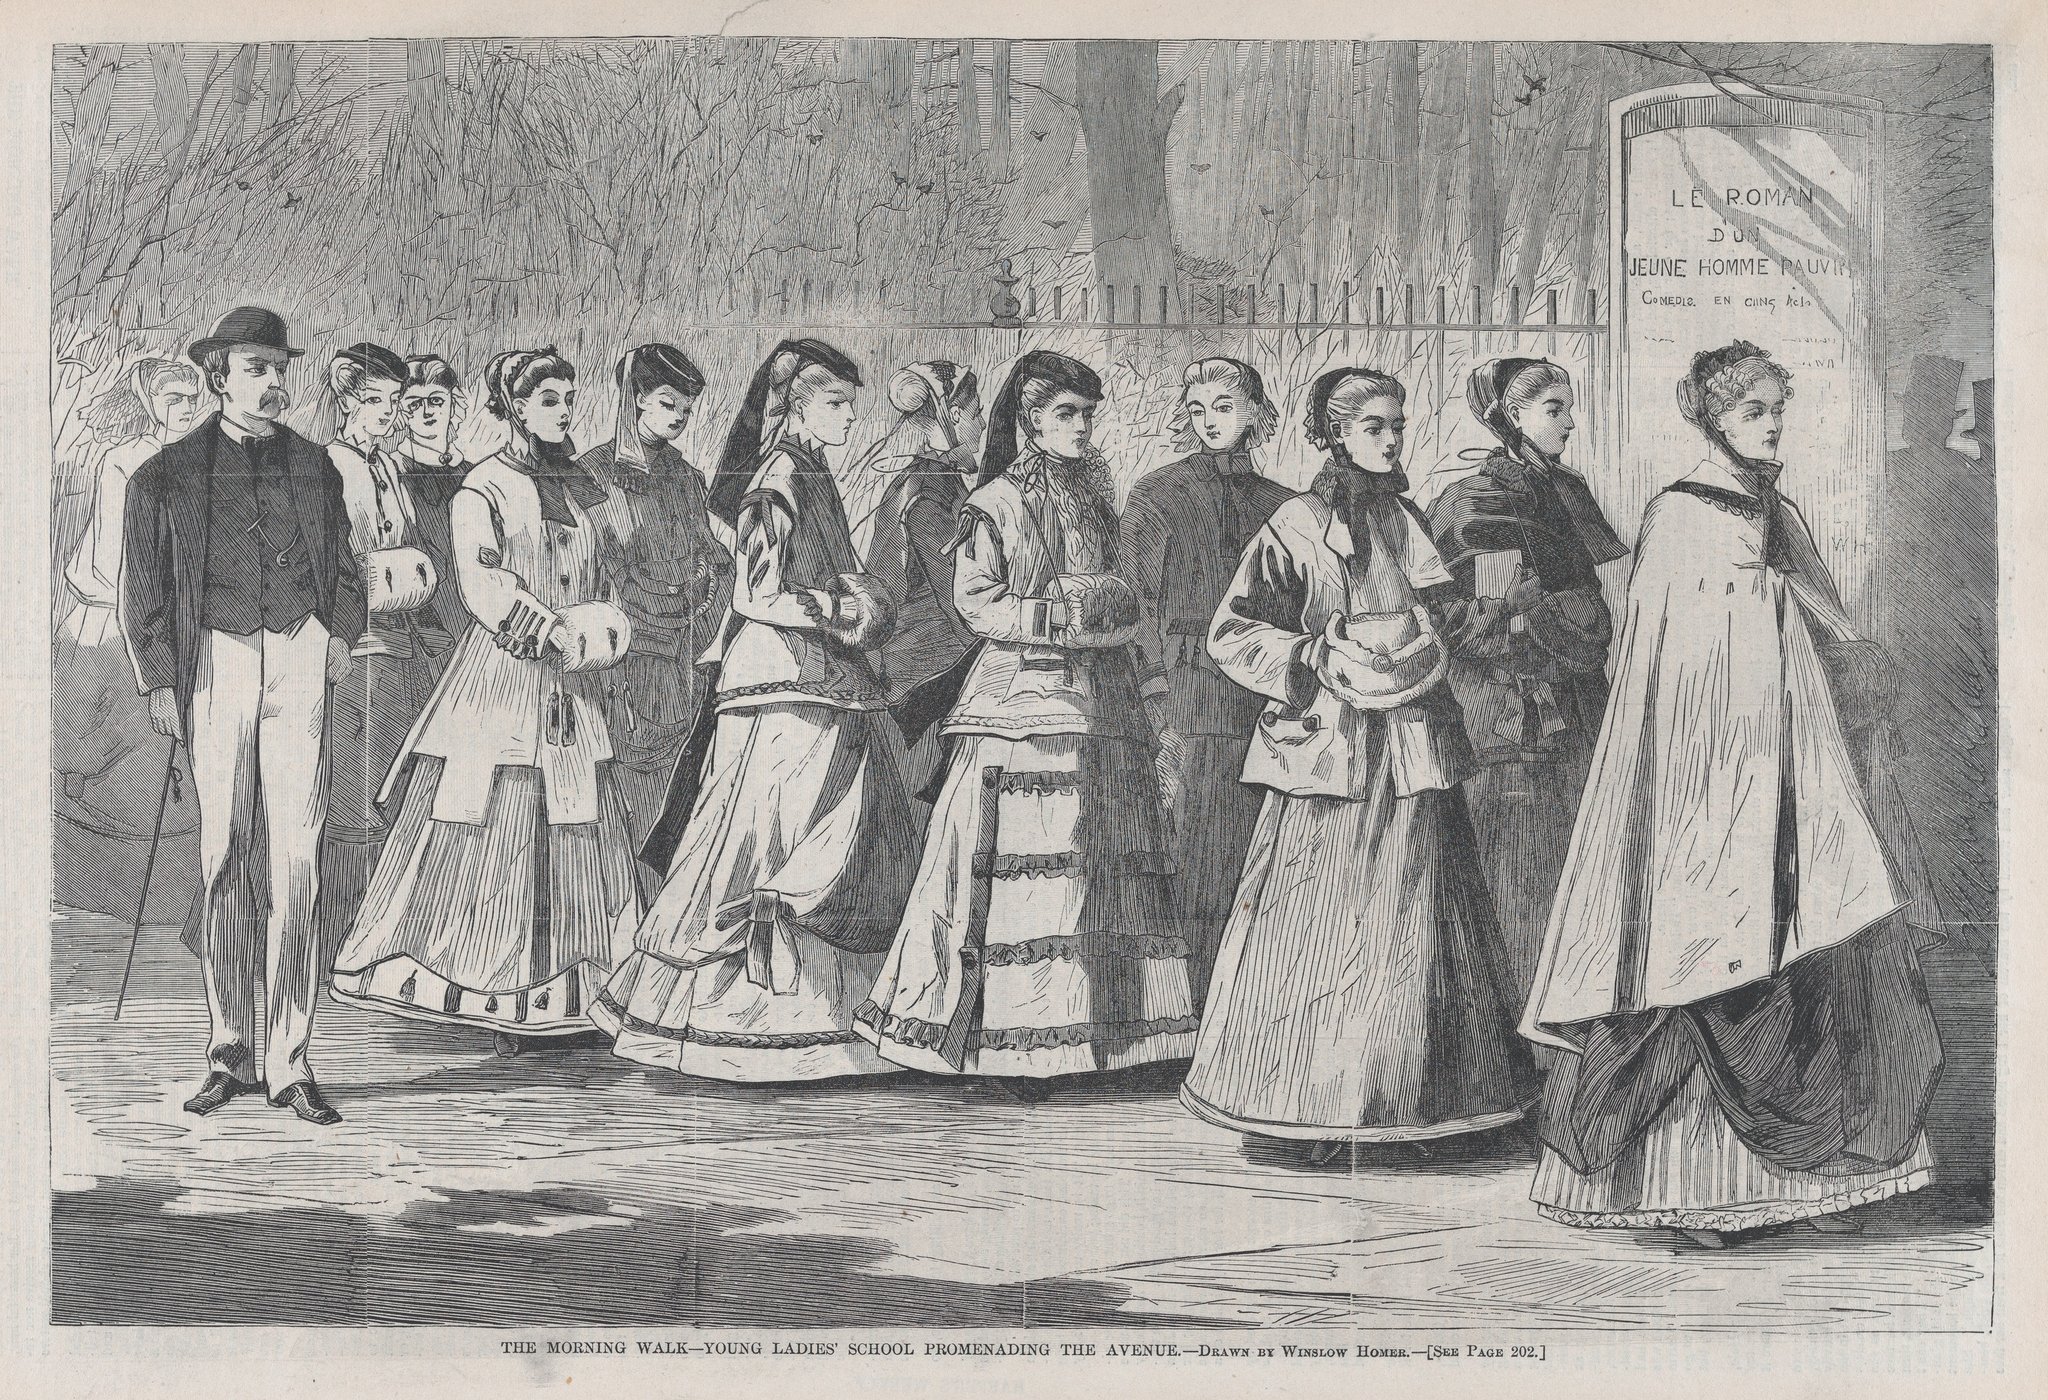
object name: print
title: The Morning Walk – The Young Ladies' School Promenading the Avenue (from "Harper's Weekly," Vol. XII)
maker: winslow homer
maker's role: artist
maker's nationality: american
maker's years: 1836-1910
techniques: engraving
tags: men,women,walking